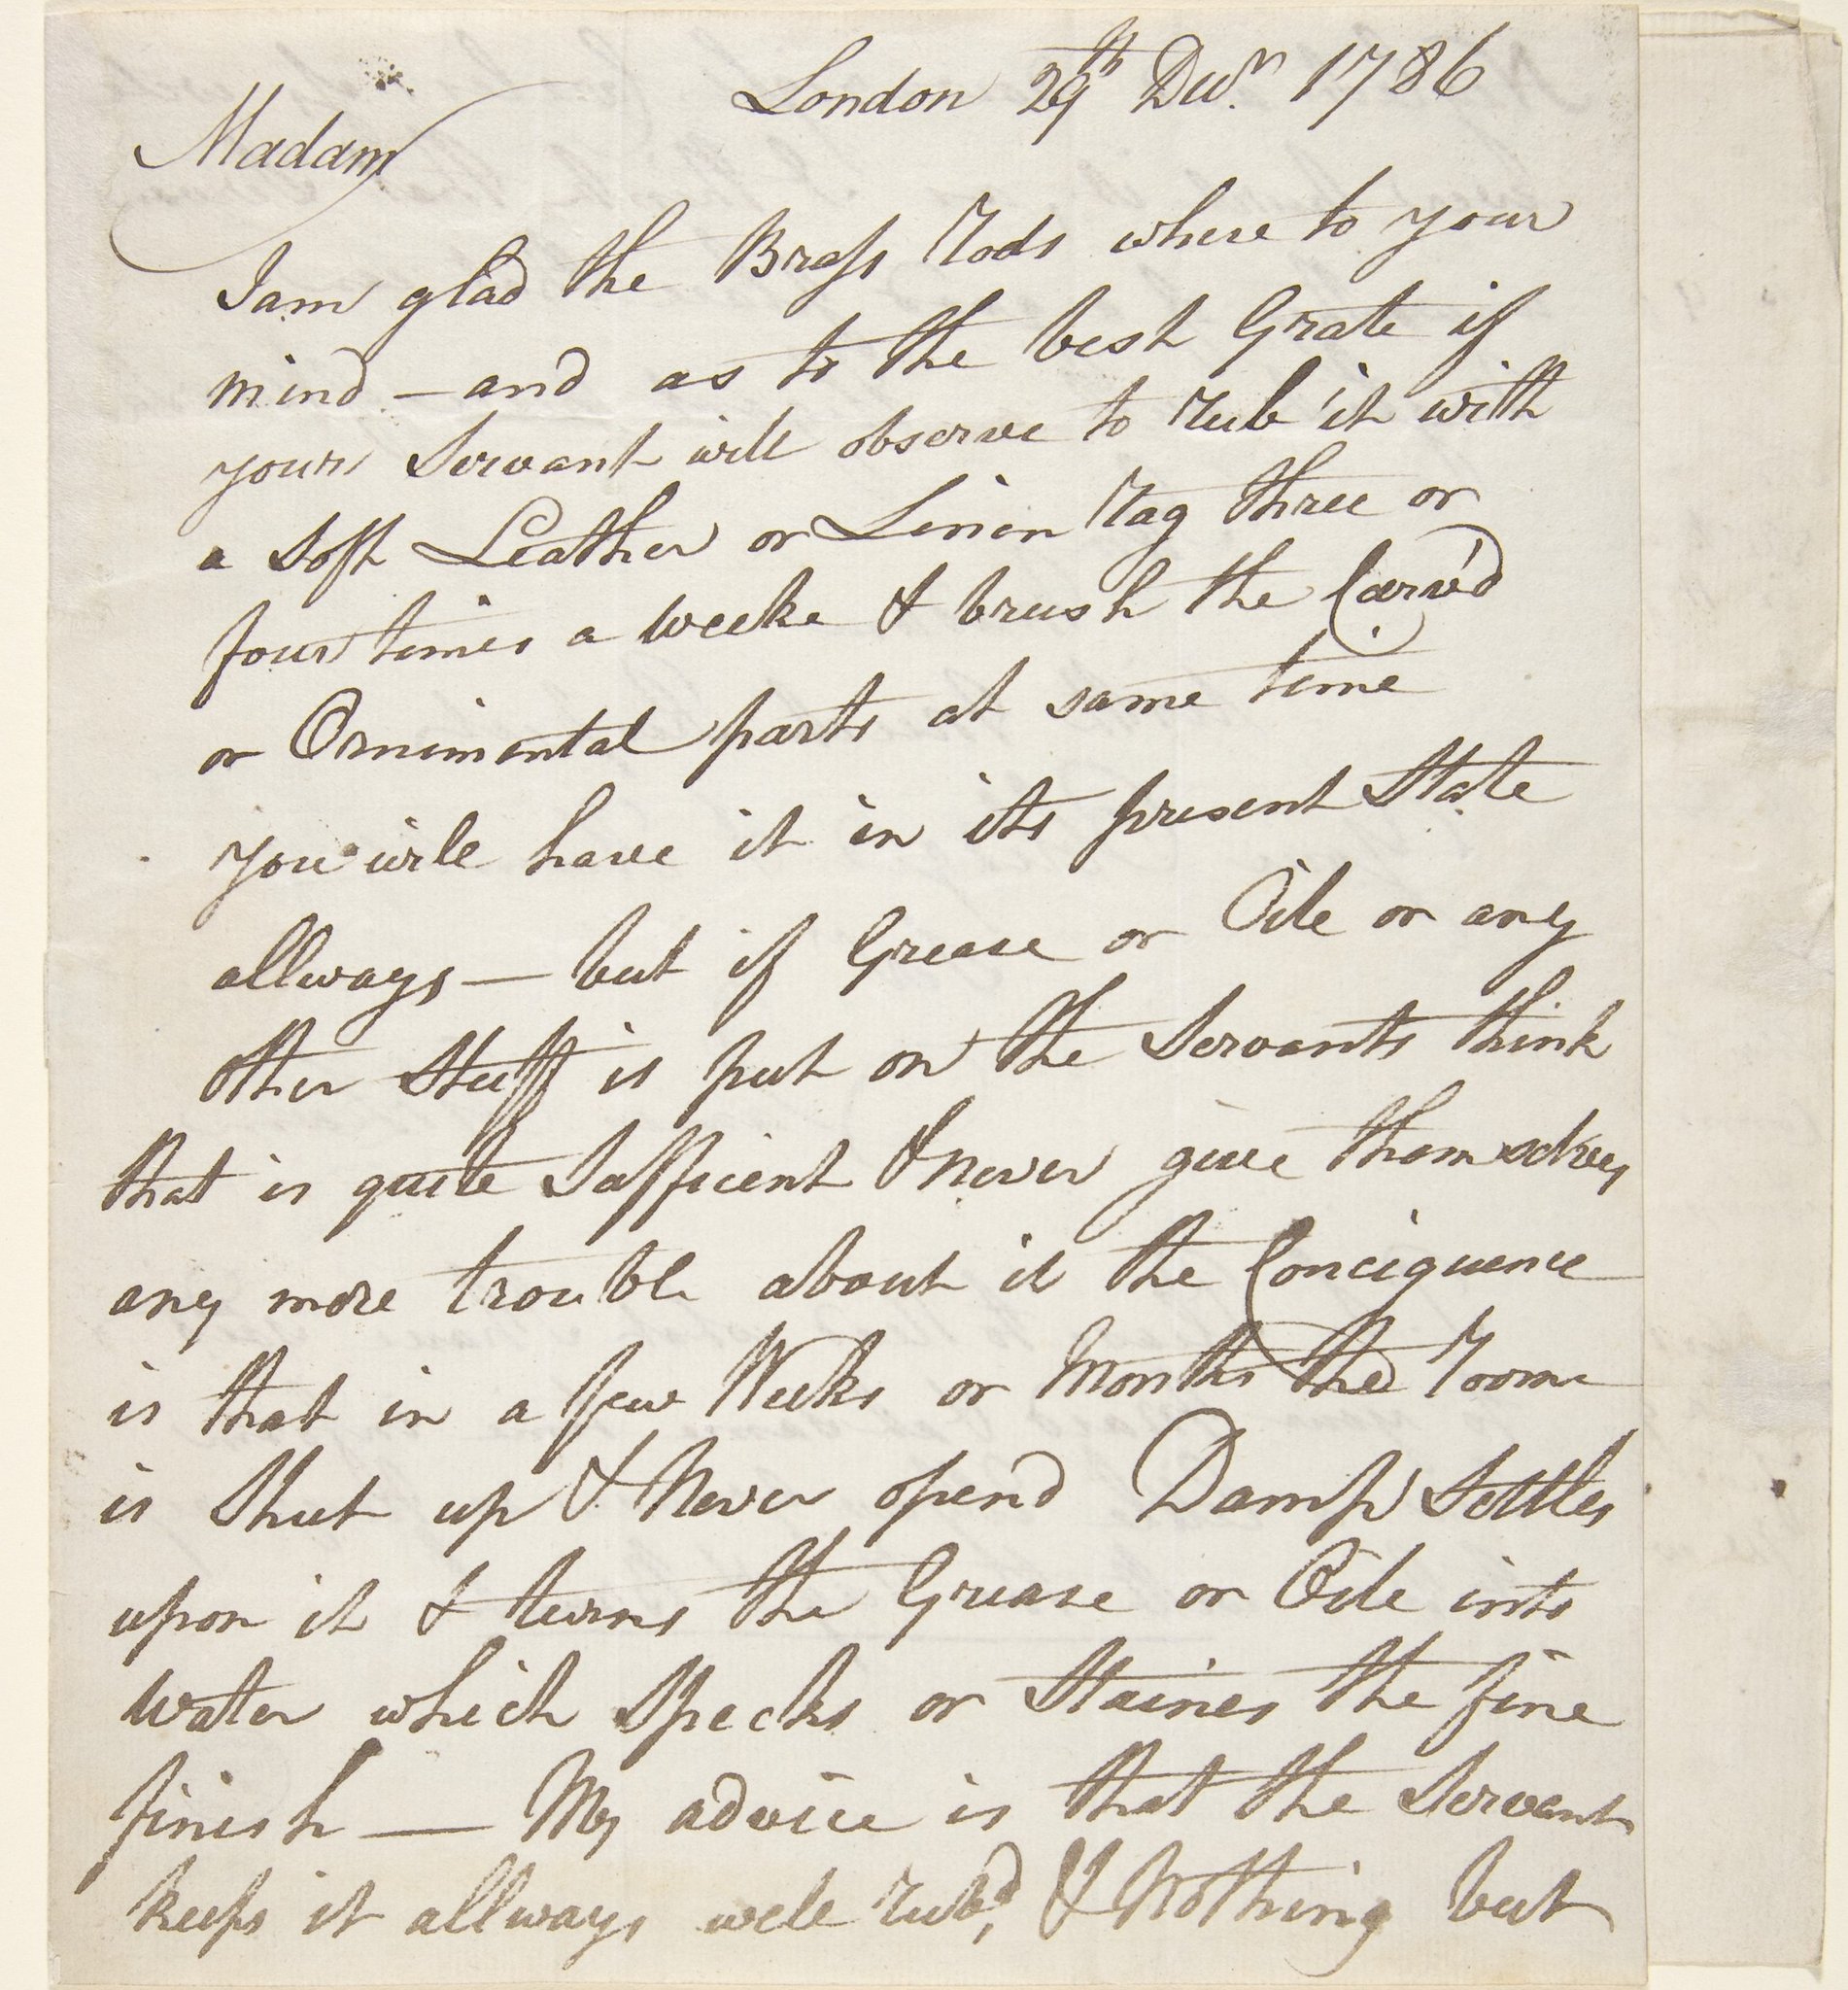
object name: letter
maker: james oldham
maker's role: author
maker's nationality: british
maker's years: 1750-1850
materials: ink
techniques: pen